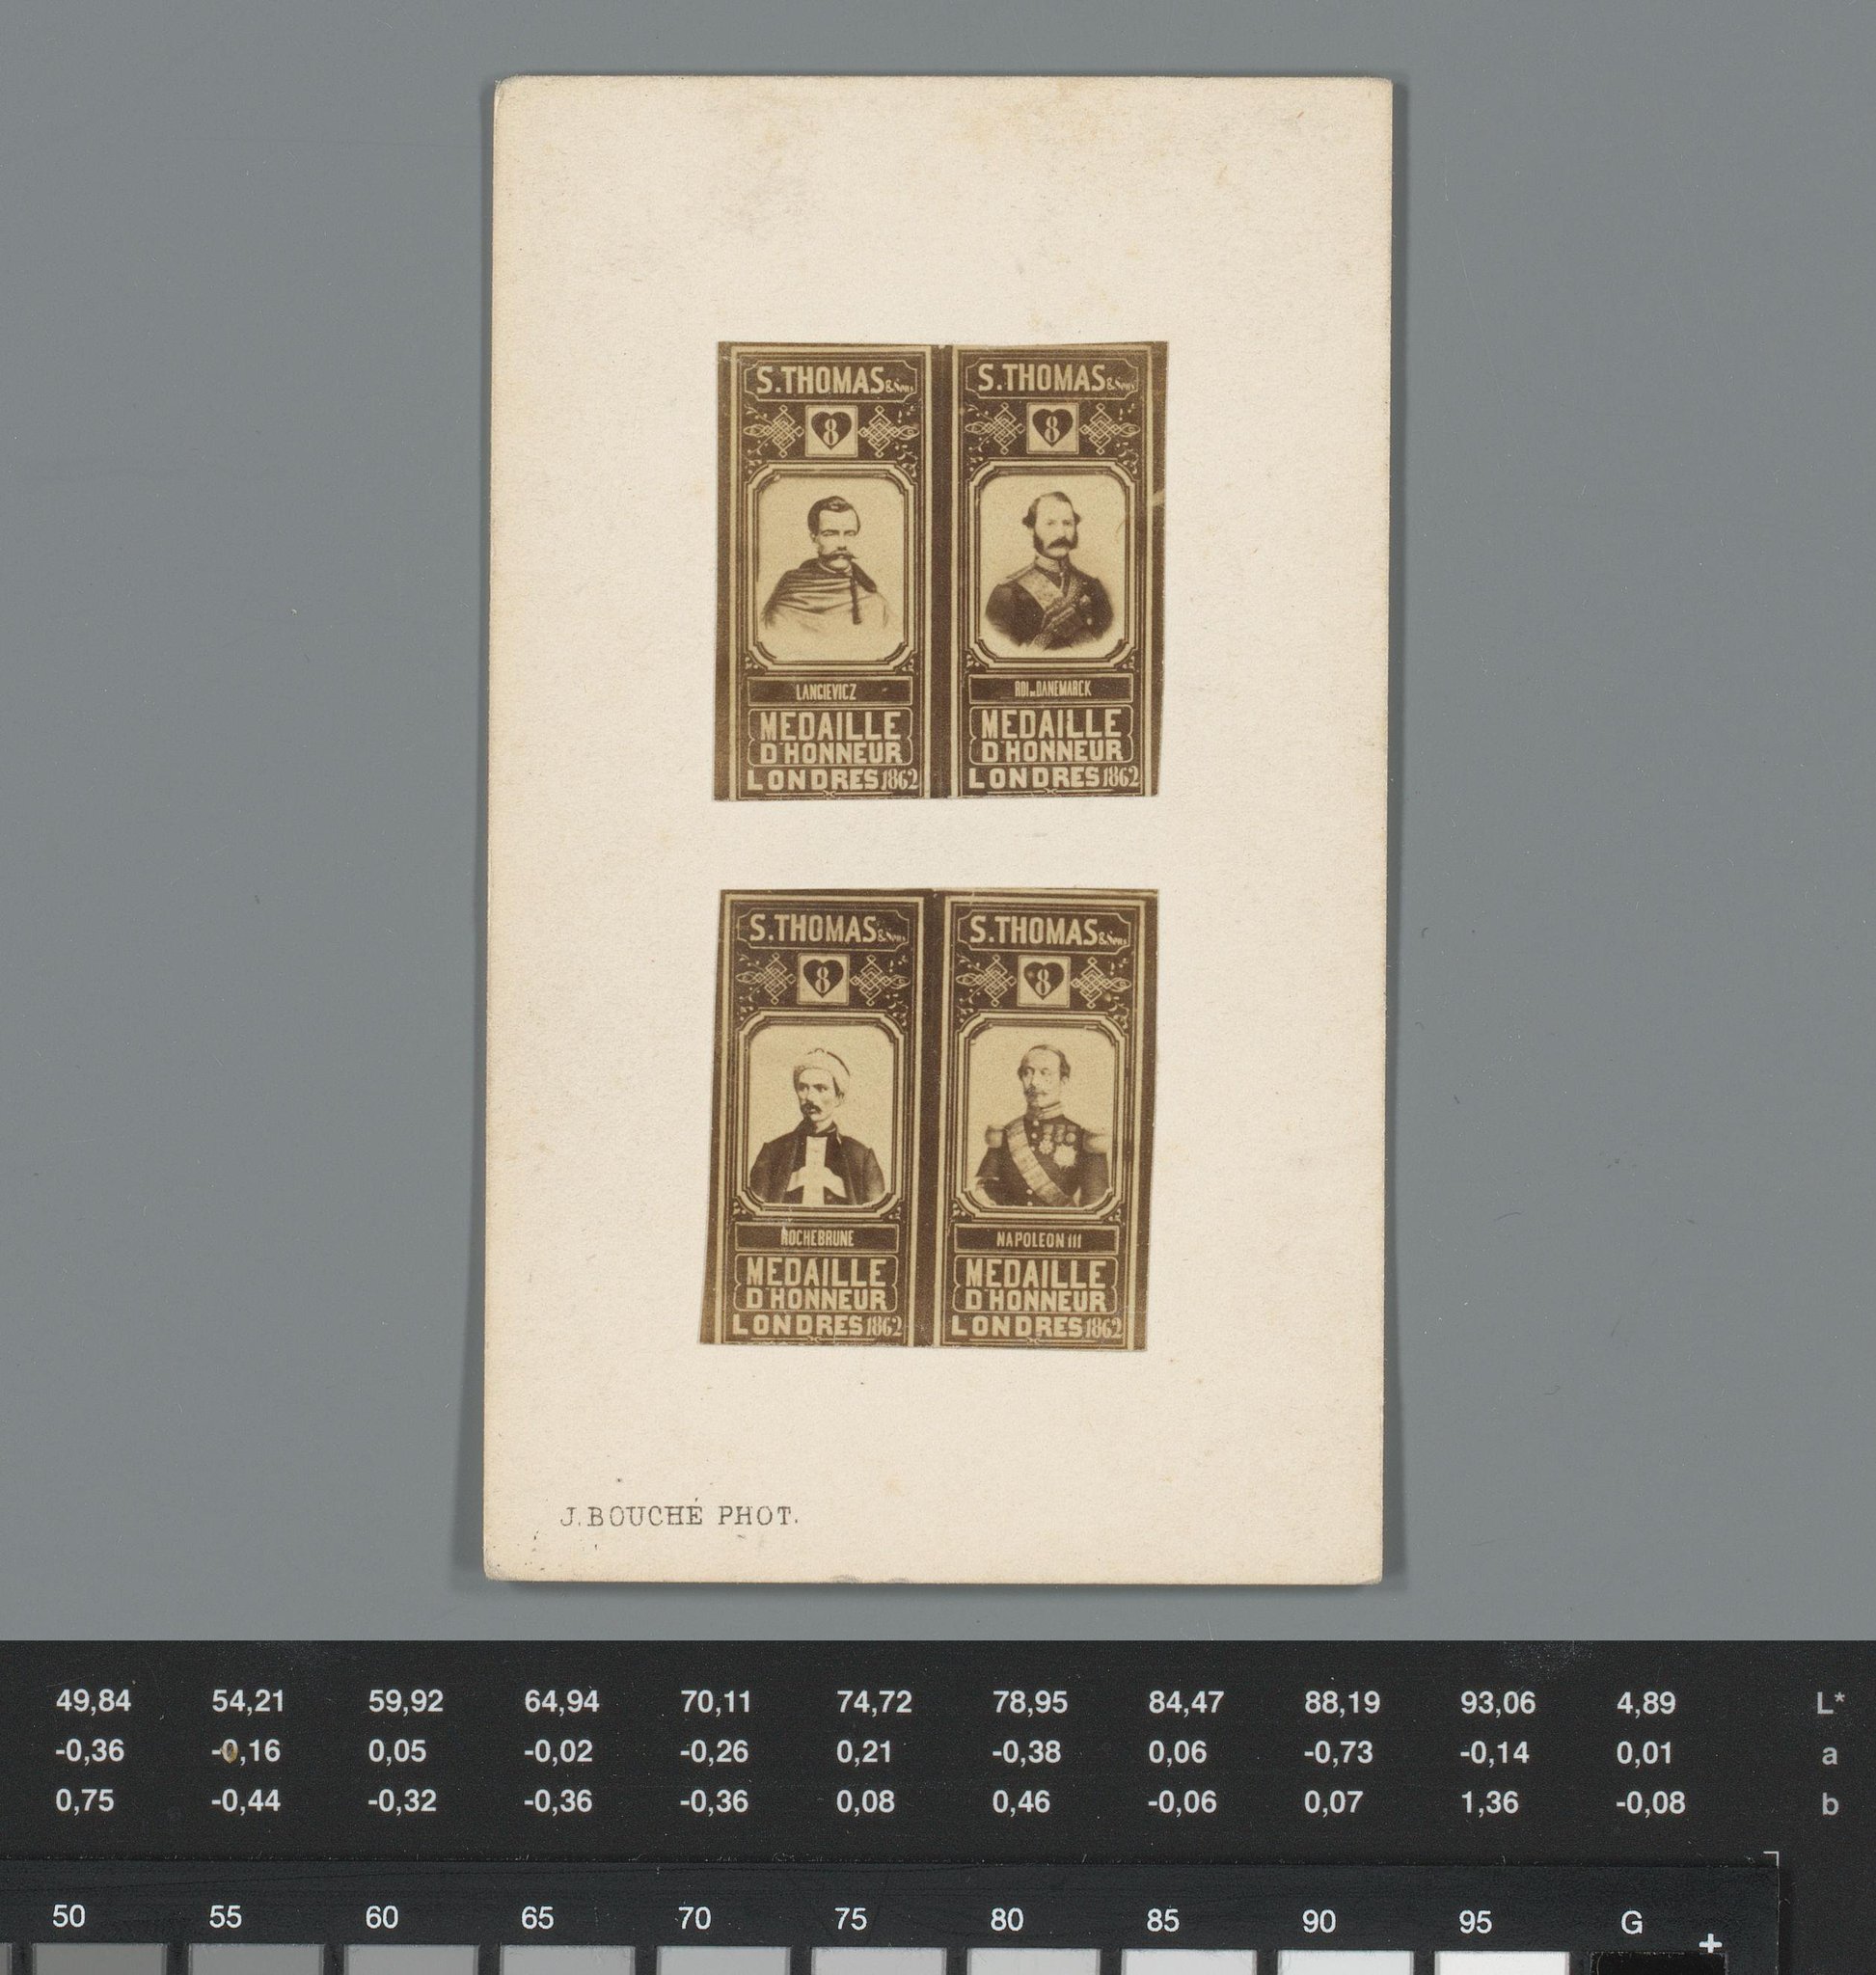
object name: carte de visite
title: Twee fotoreproducties met vier portretten van Marian Langiewicz, Christiaan IX van Denemarken, François Rochebrune en Napoleon III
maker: j. bouché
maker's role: fotograaf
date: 1862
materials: cardboard, photographic support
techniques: albumen print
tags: paris, london, napoleon iii (keizer der fransen), historical persons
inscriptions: address and date: ‘DEUX MENTIONS HONORABLES 1851-1861./ J. BOUCHÉ/ PHOTOGRAPHE/ Place Drouet d'Erlon, 28./ REIMS/ DEUX MEDAILLES ARGENT& BRONZE 1853-1855.’, name: ‘J. BOUCHÉ PHOT.’